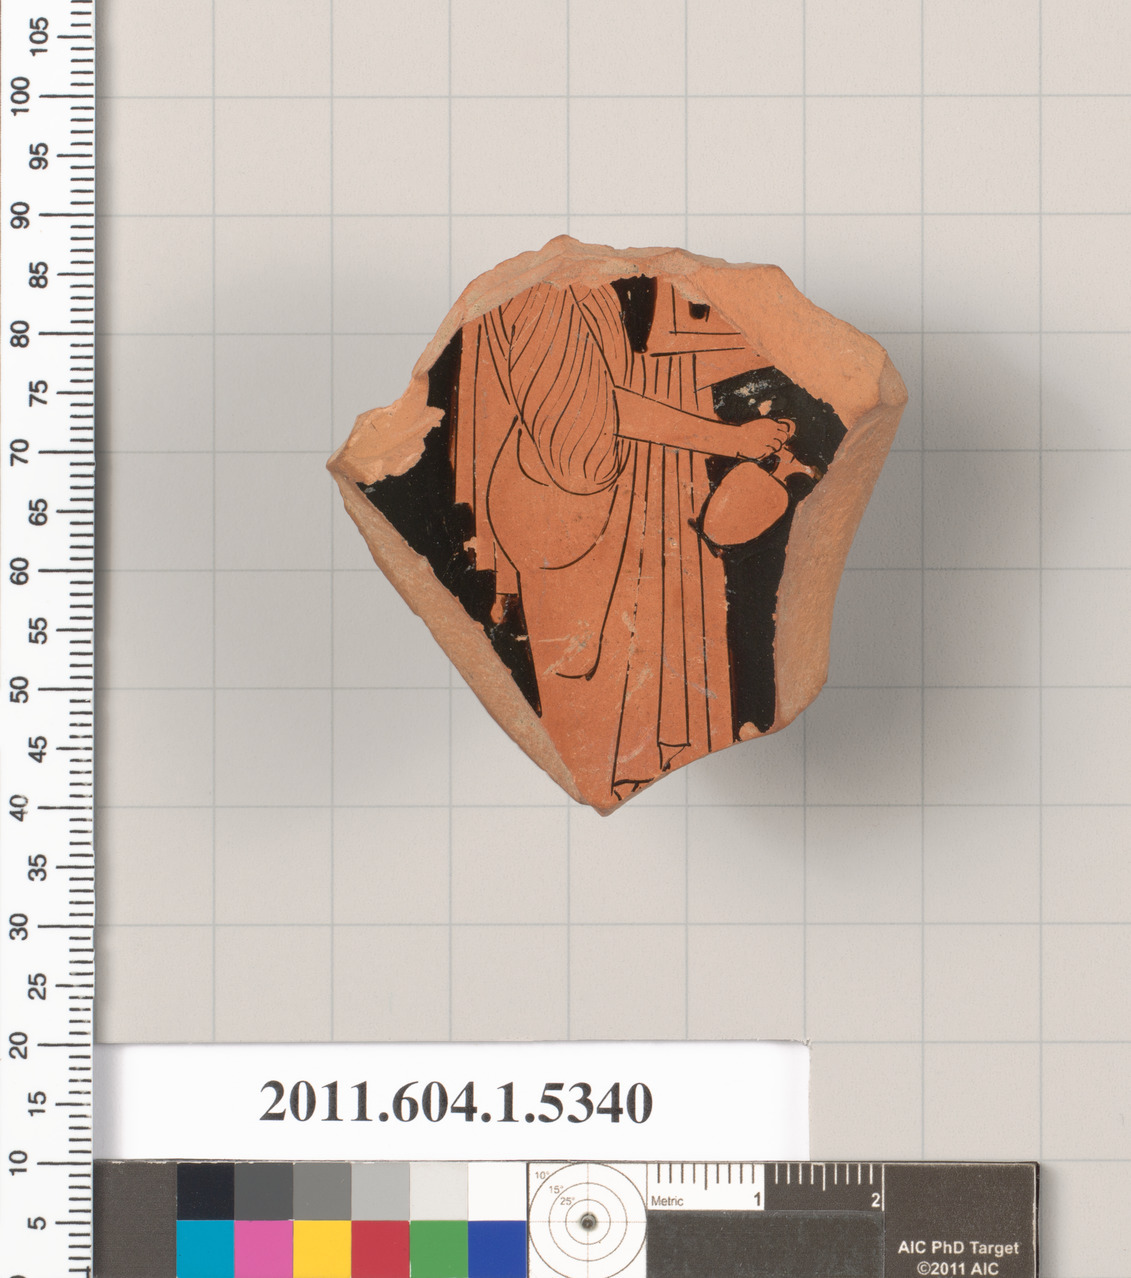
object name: kylix fragment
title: Terracotta fragment of a kylix (drinking cup)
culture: greek, attic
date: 475-451 BCE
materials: terracotta